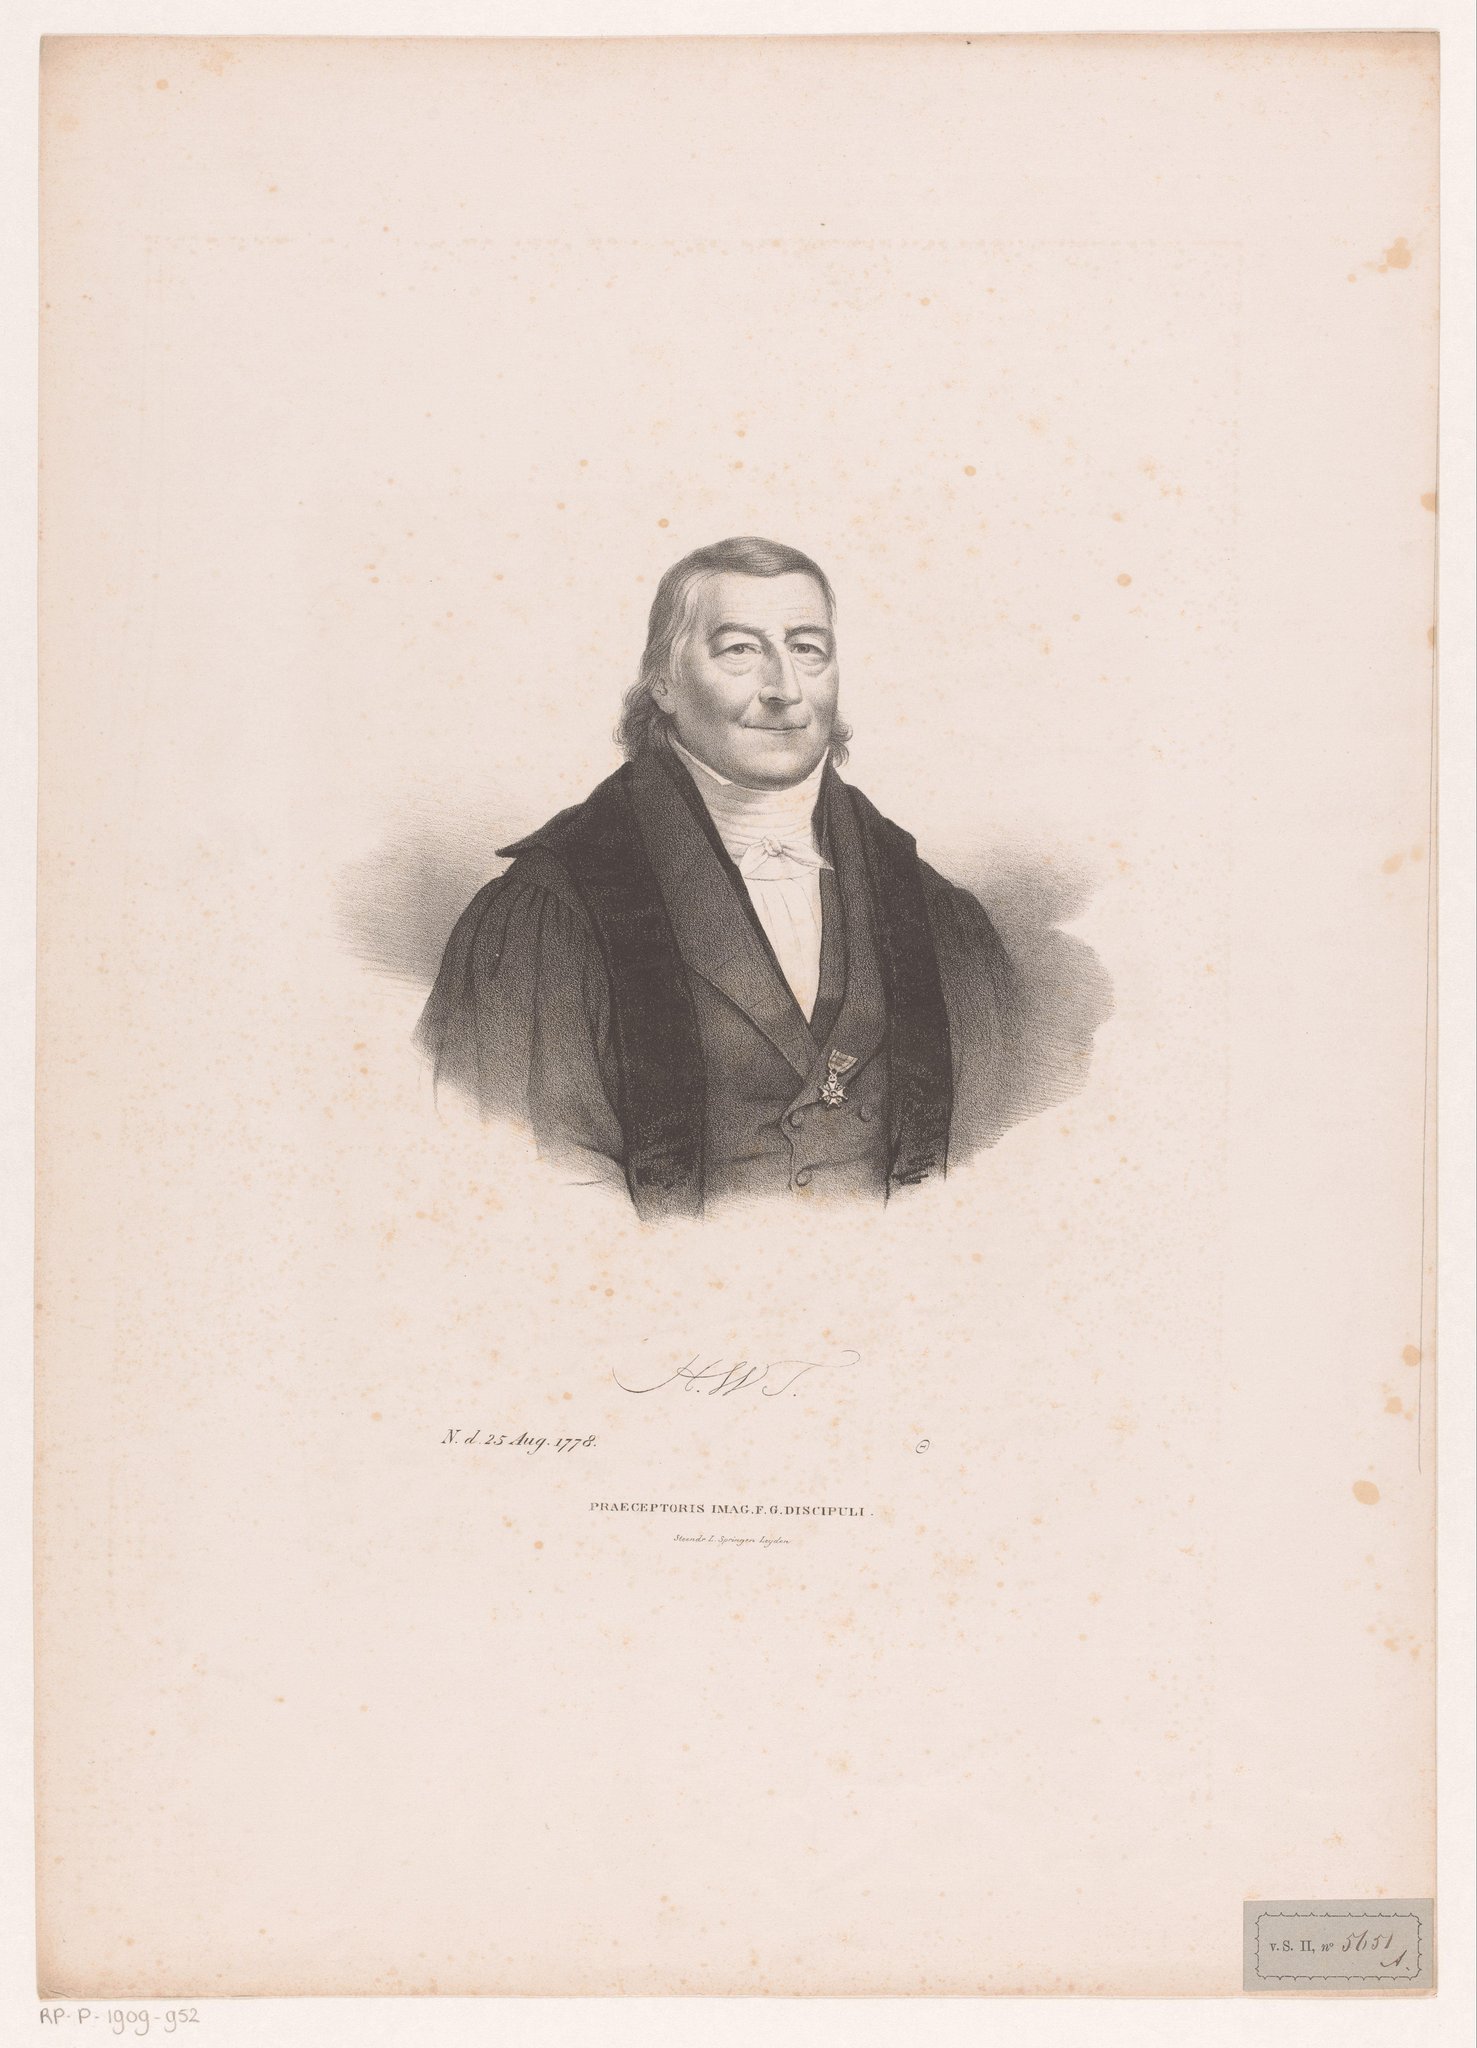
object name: print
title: Portret van Hendrik Willem Tydeman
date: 1809-1863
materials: paper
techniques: lithograph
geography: leiden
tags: utrecht, leiden, hendrik willem tydeman, historical persons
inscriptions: collector's mark: Lugt 2228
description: Onder het portret de signatuur van de geportretteerde.